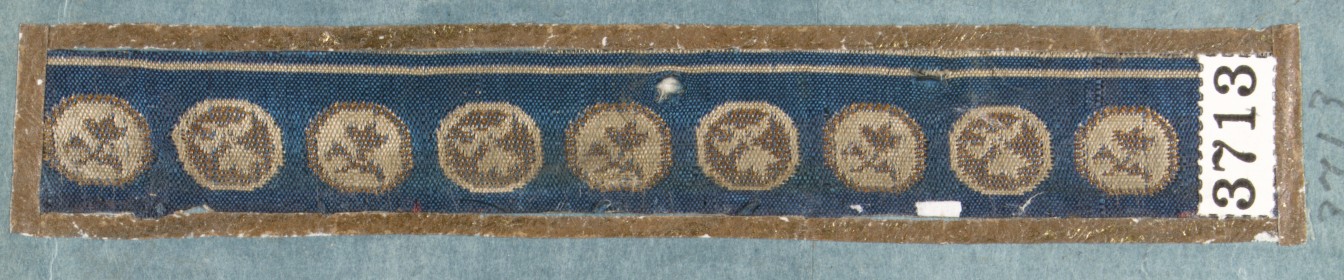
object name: sample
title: Textile Sample from Sample Book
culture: japanese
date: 1801-1900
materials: silk